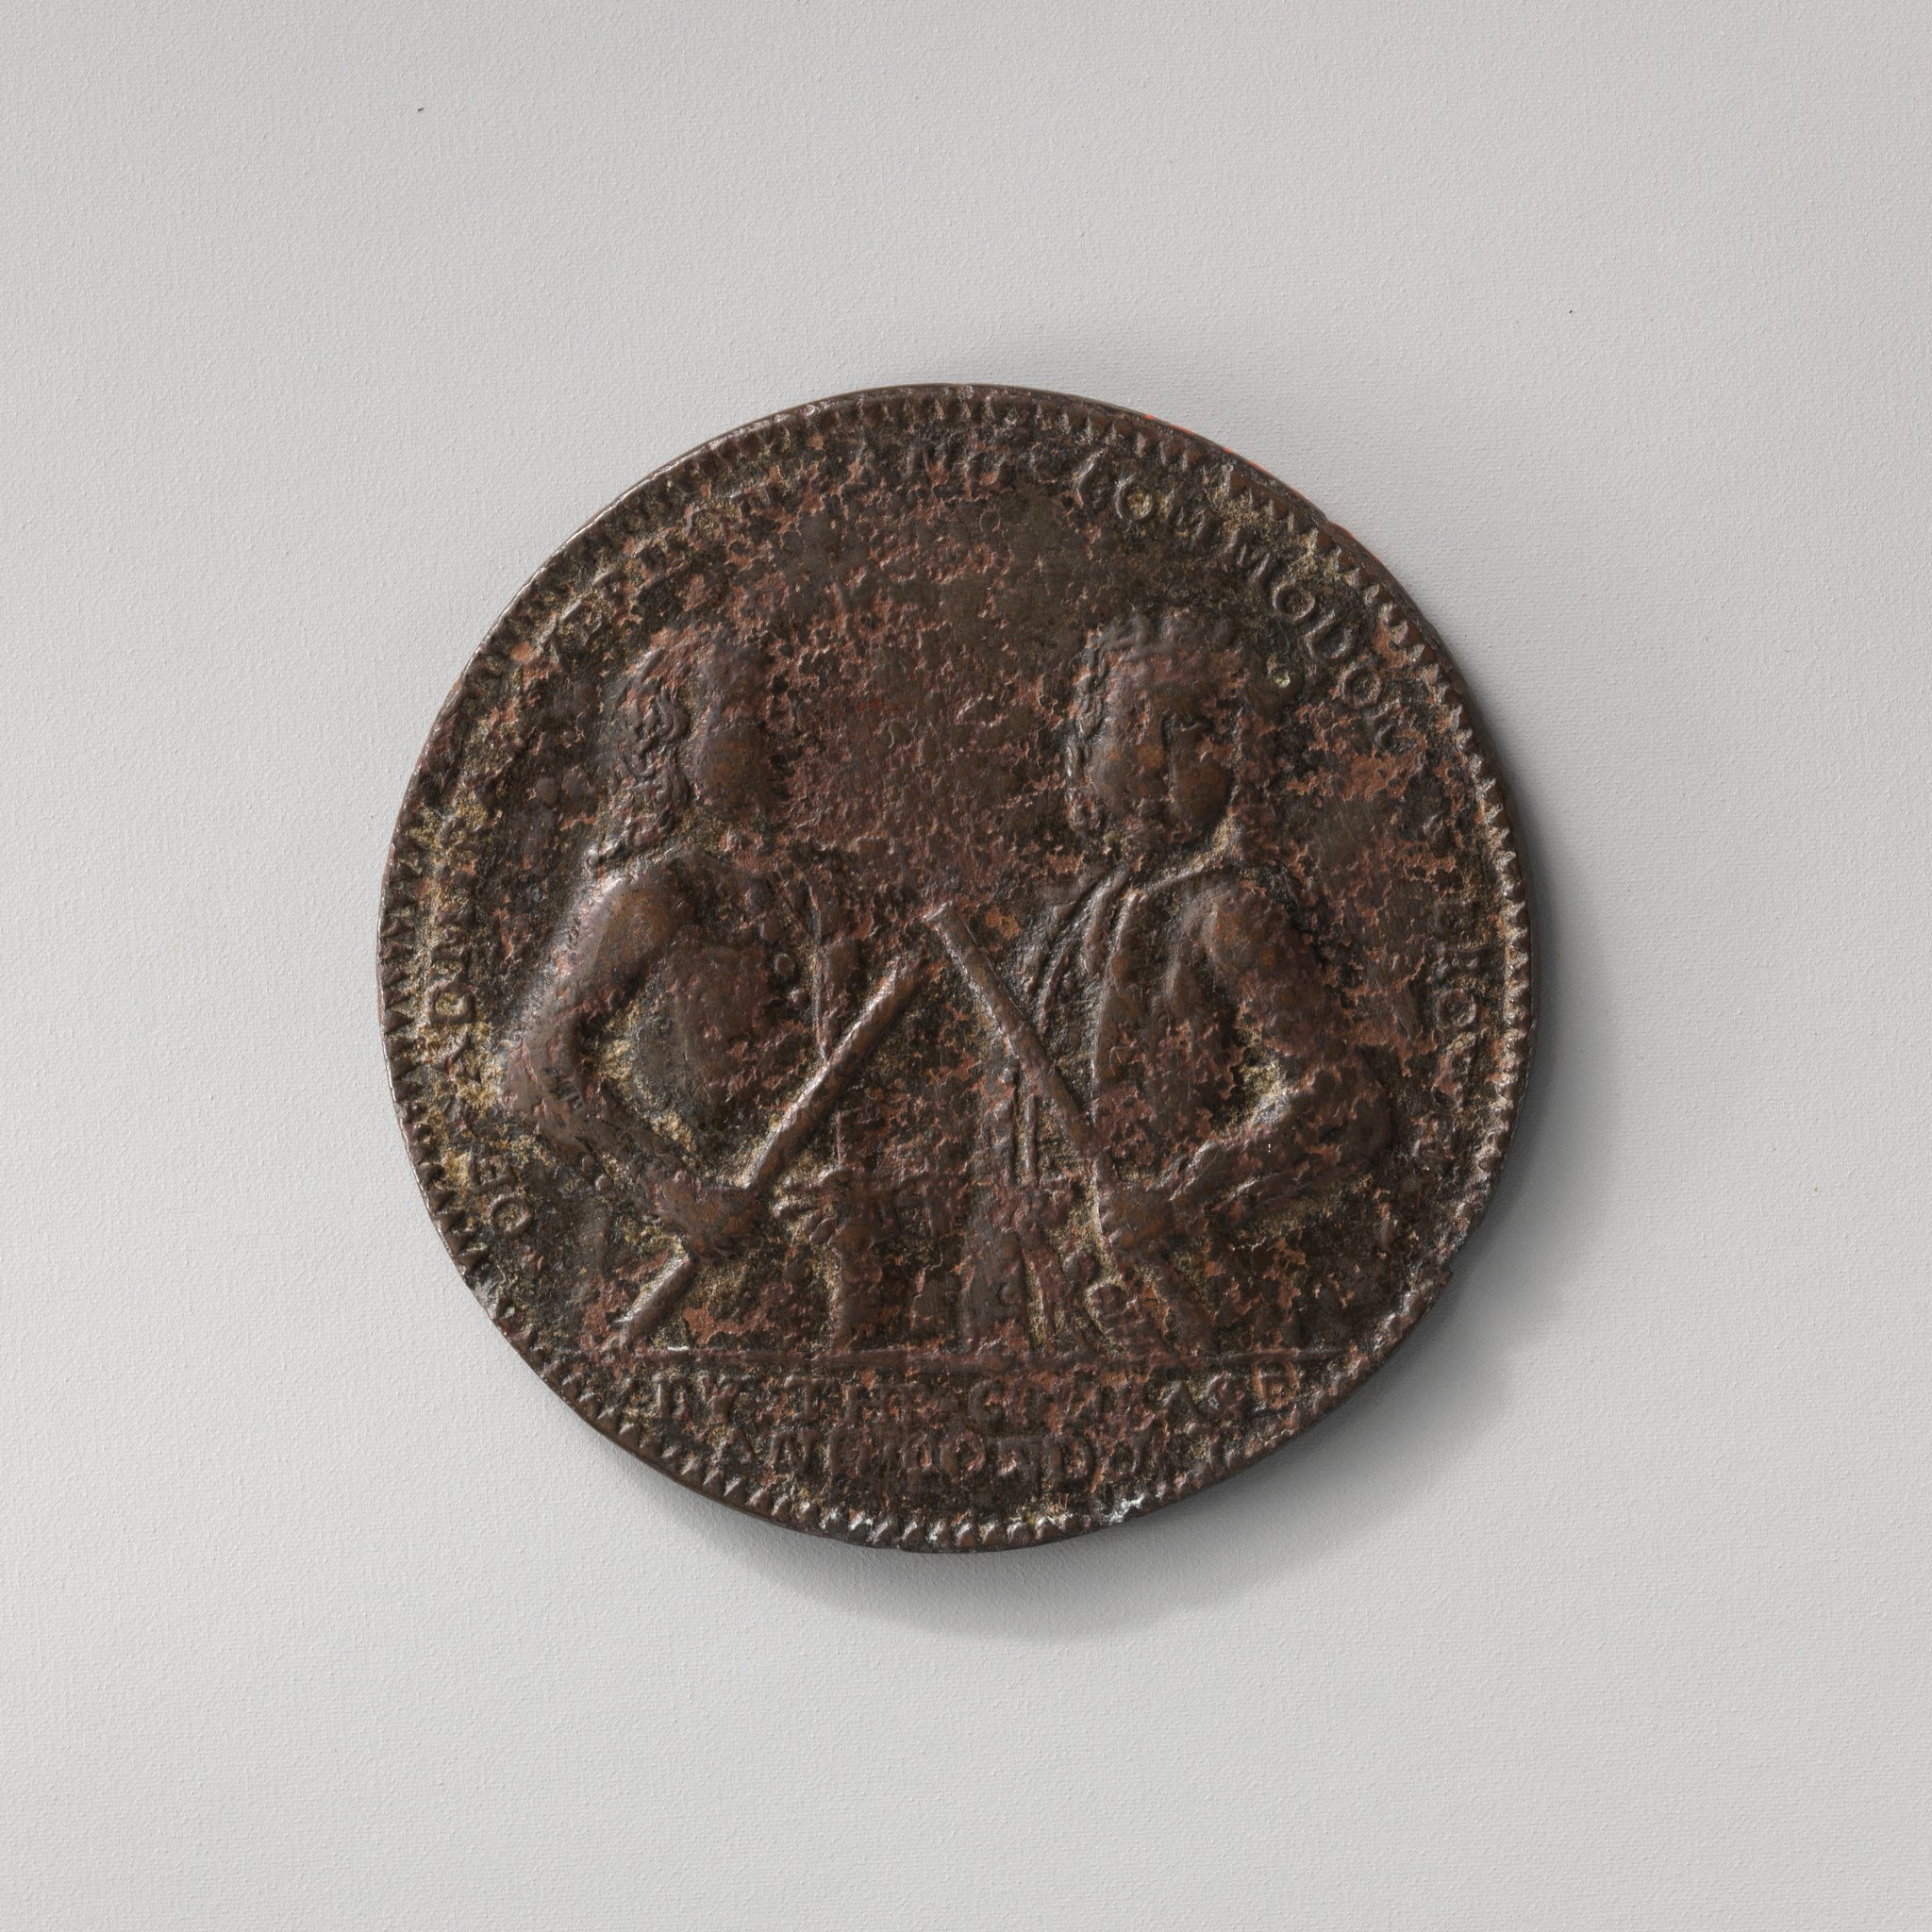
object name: medal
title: The taking of Porto Bello by Admiral Vernon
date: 1739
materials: copper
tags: men,admirals